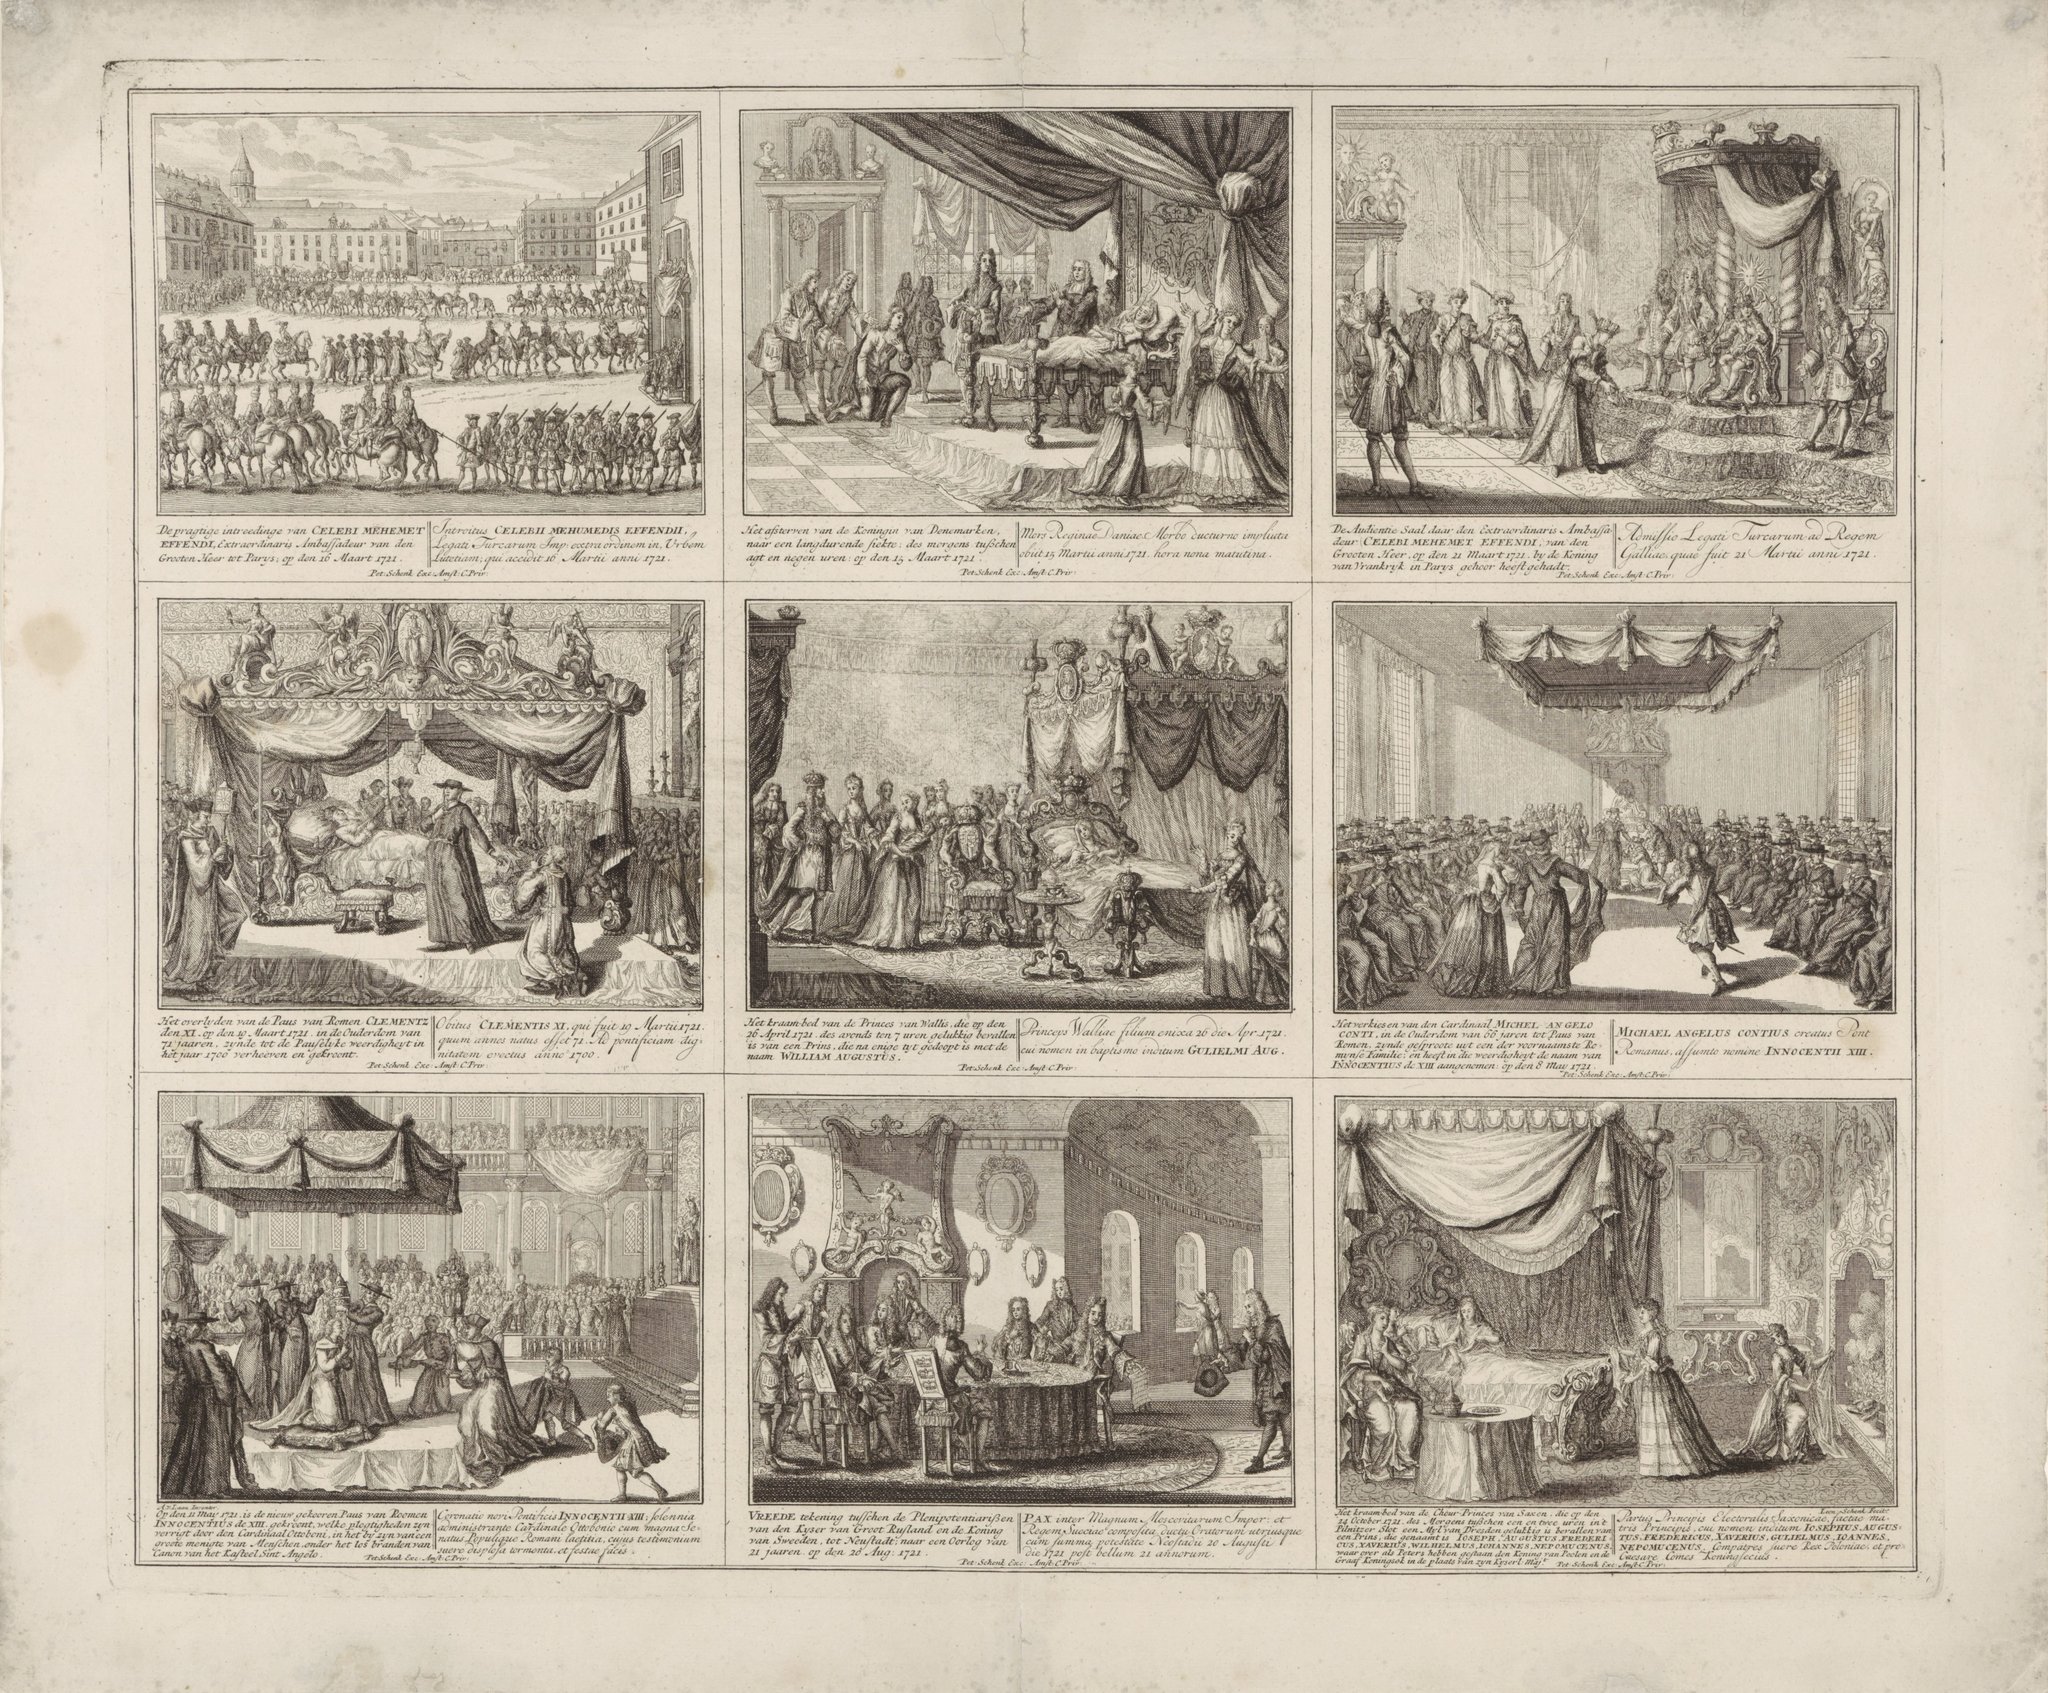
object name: print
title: Schouwburg van den oorlog (blad XXII), 1721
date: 1721-1722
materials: paper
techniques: etching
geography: amsterdam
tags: rome, clergyman, clemens xi, lying-in room, bedroom, historical events and situations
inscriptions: collector's mark: Lugt 2228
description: Blad met negen voorstellingen van gebeurtenissen uit het jaar 1721. Rechtsonder de bevalling van de keurvorstin van Saksen te Pillnitz, 24 oktober 1721.